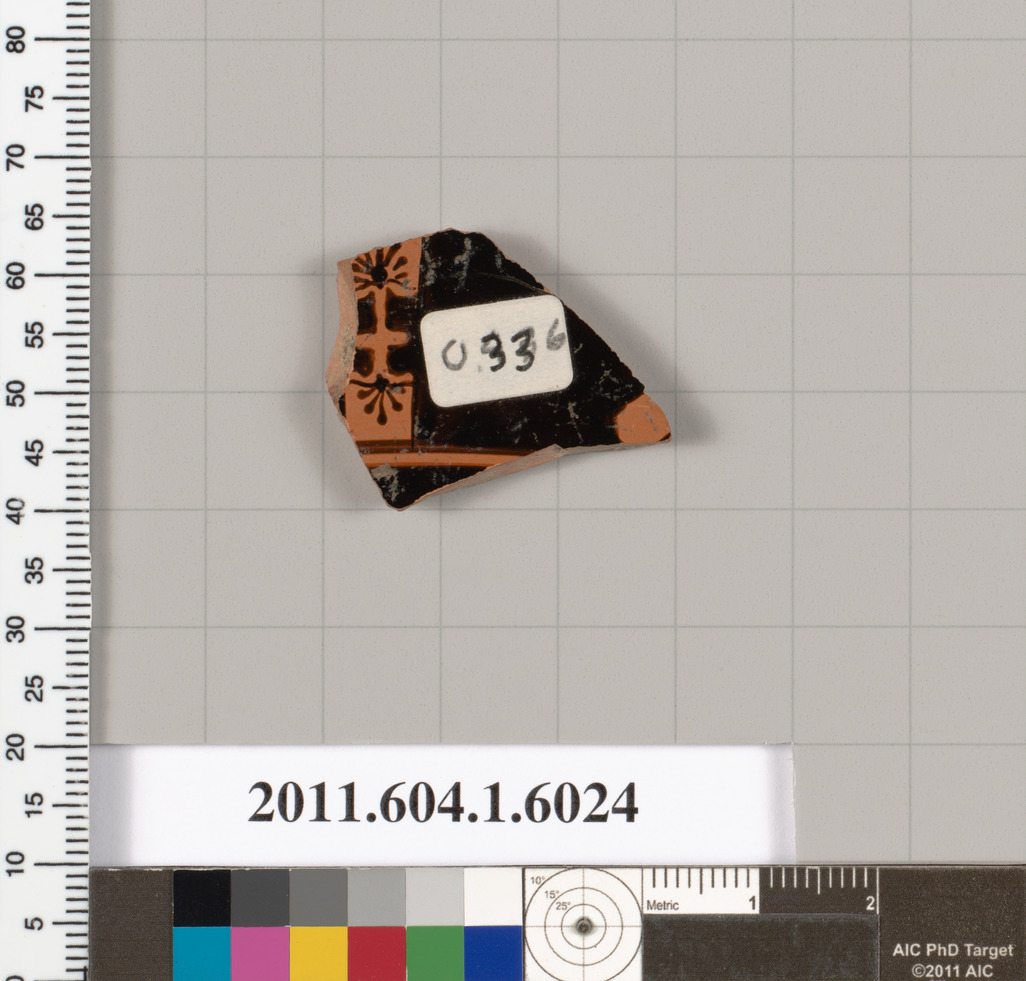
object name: kylix fragment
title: Terracotta fragment of a kylix (drinking cup)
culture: greek, attic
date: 510-500 BCE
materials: terracotta